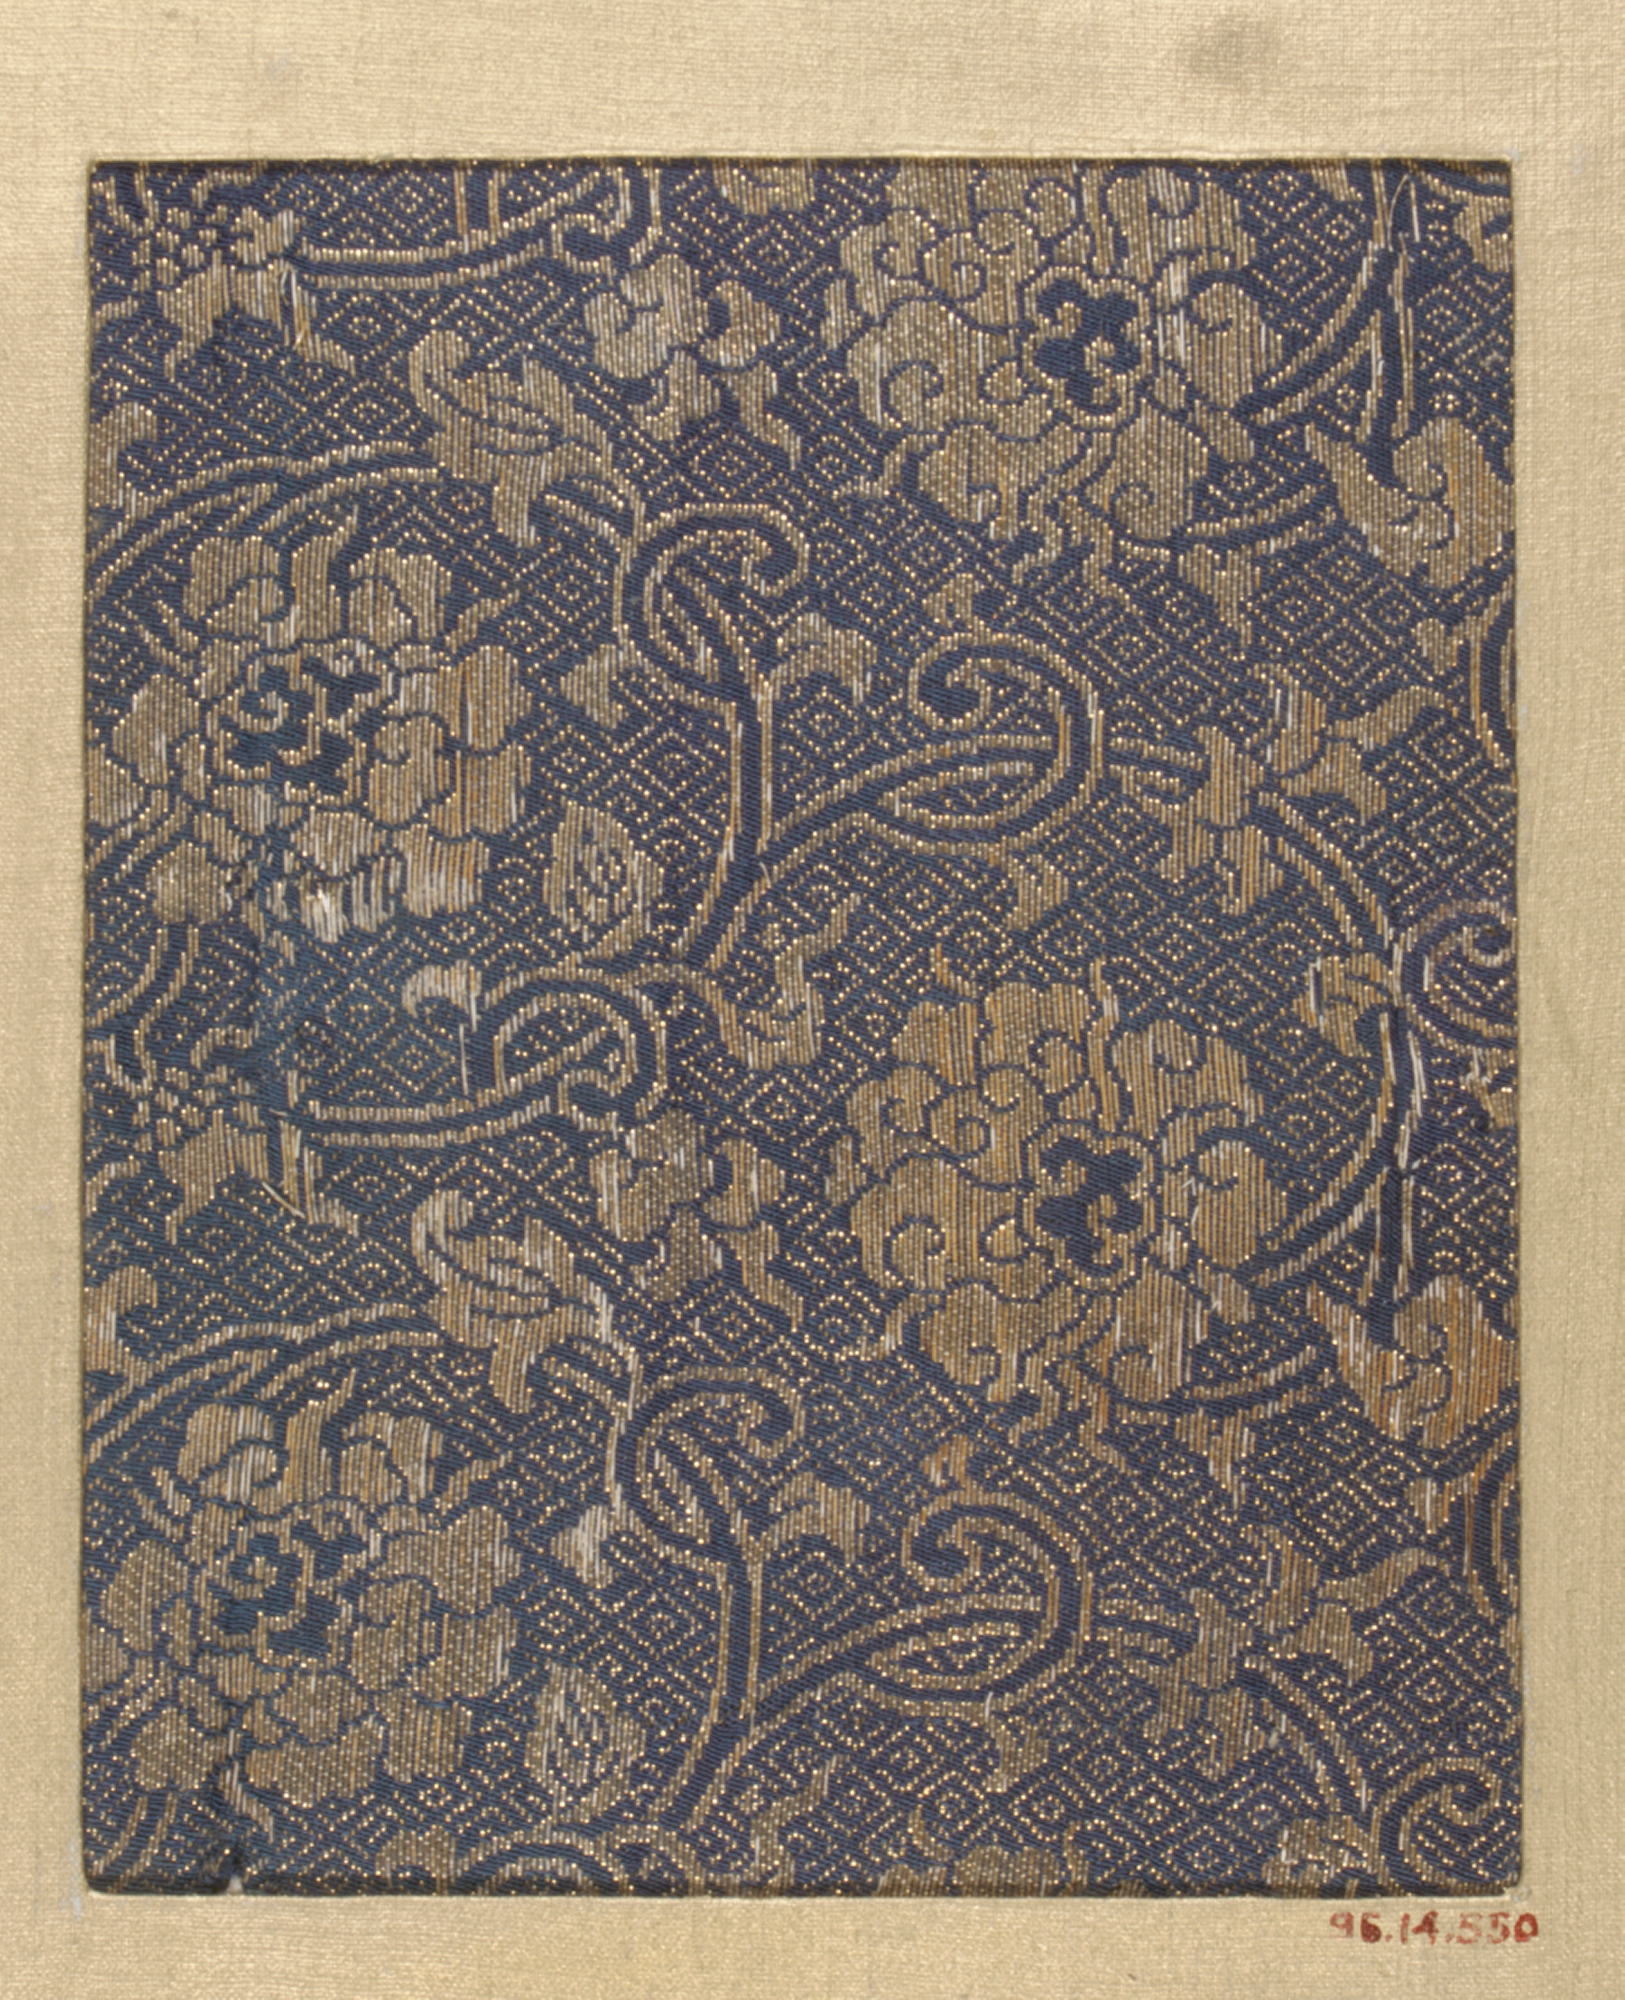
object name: piece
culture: japanese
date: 1701-1900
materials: metal thread, silk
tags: flowers